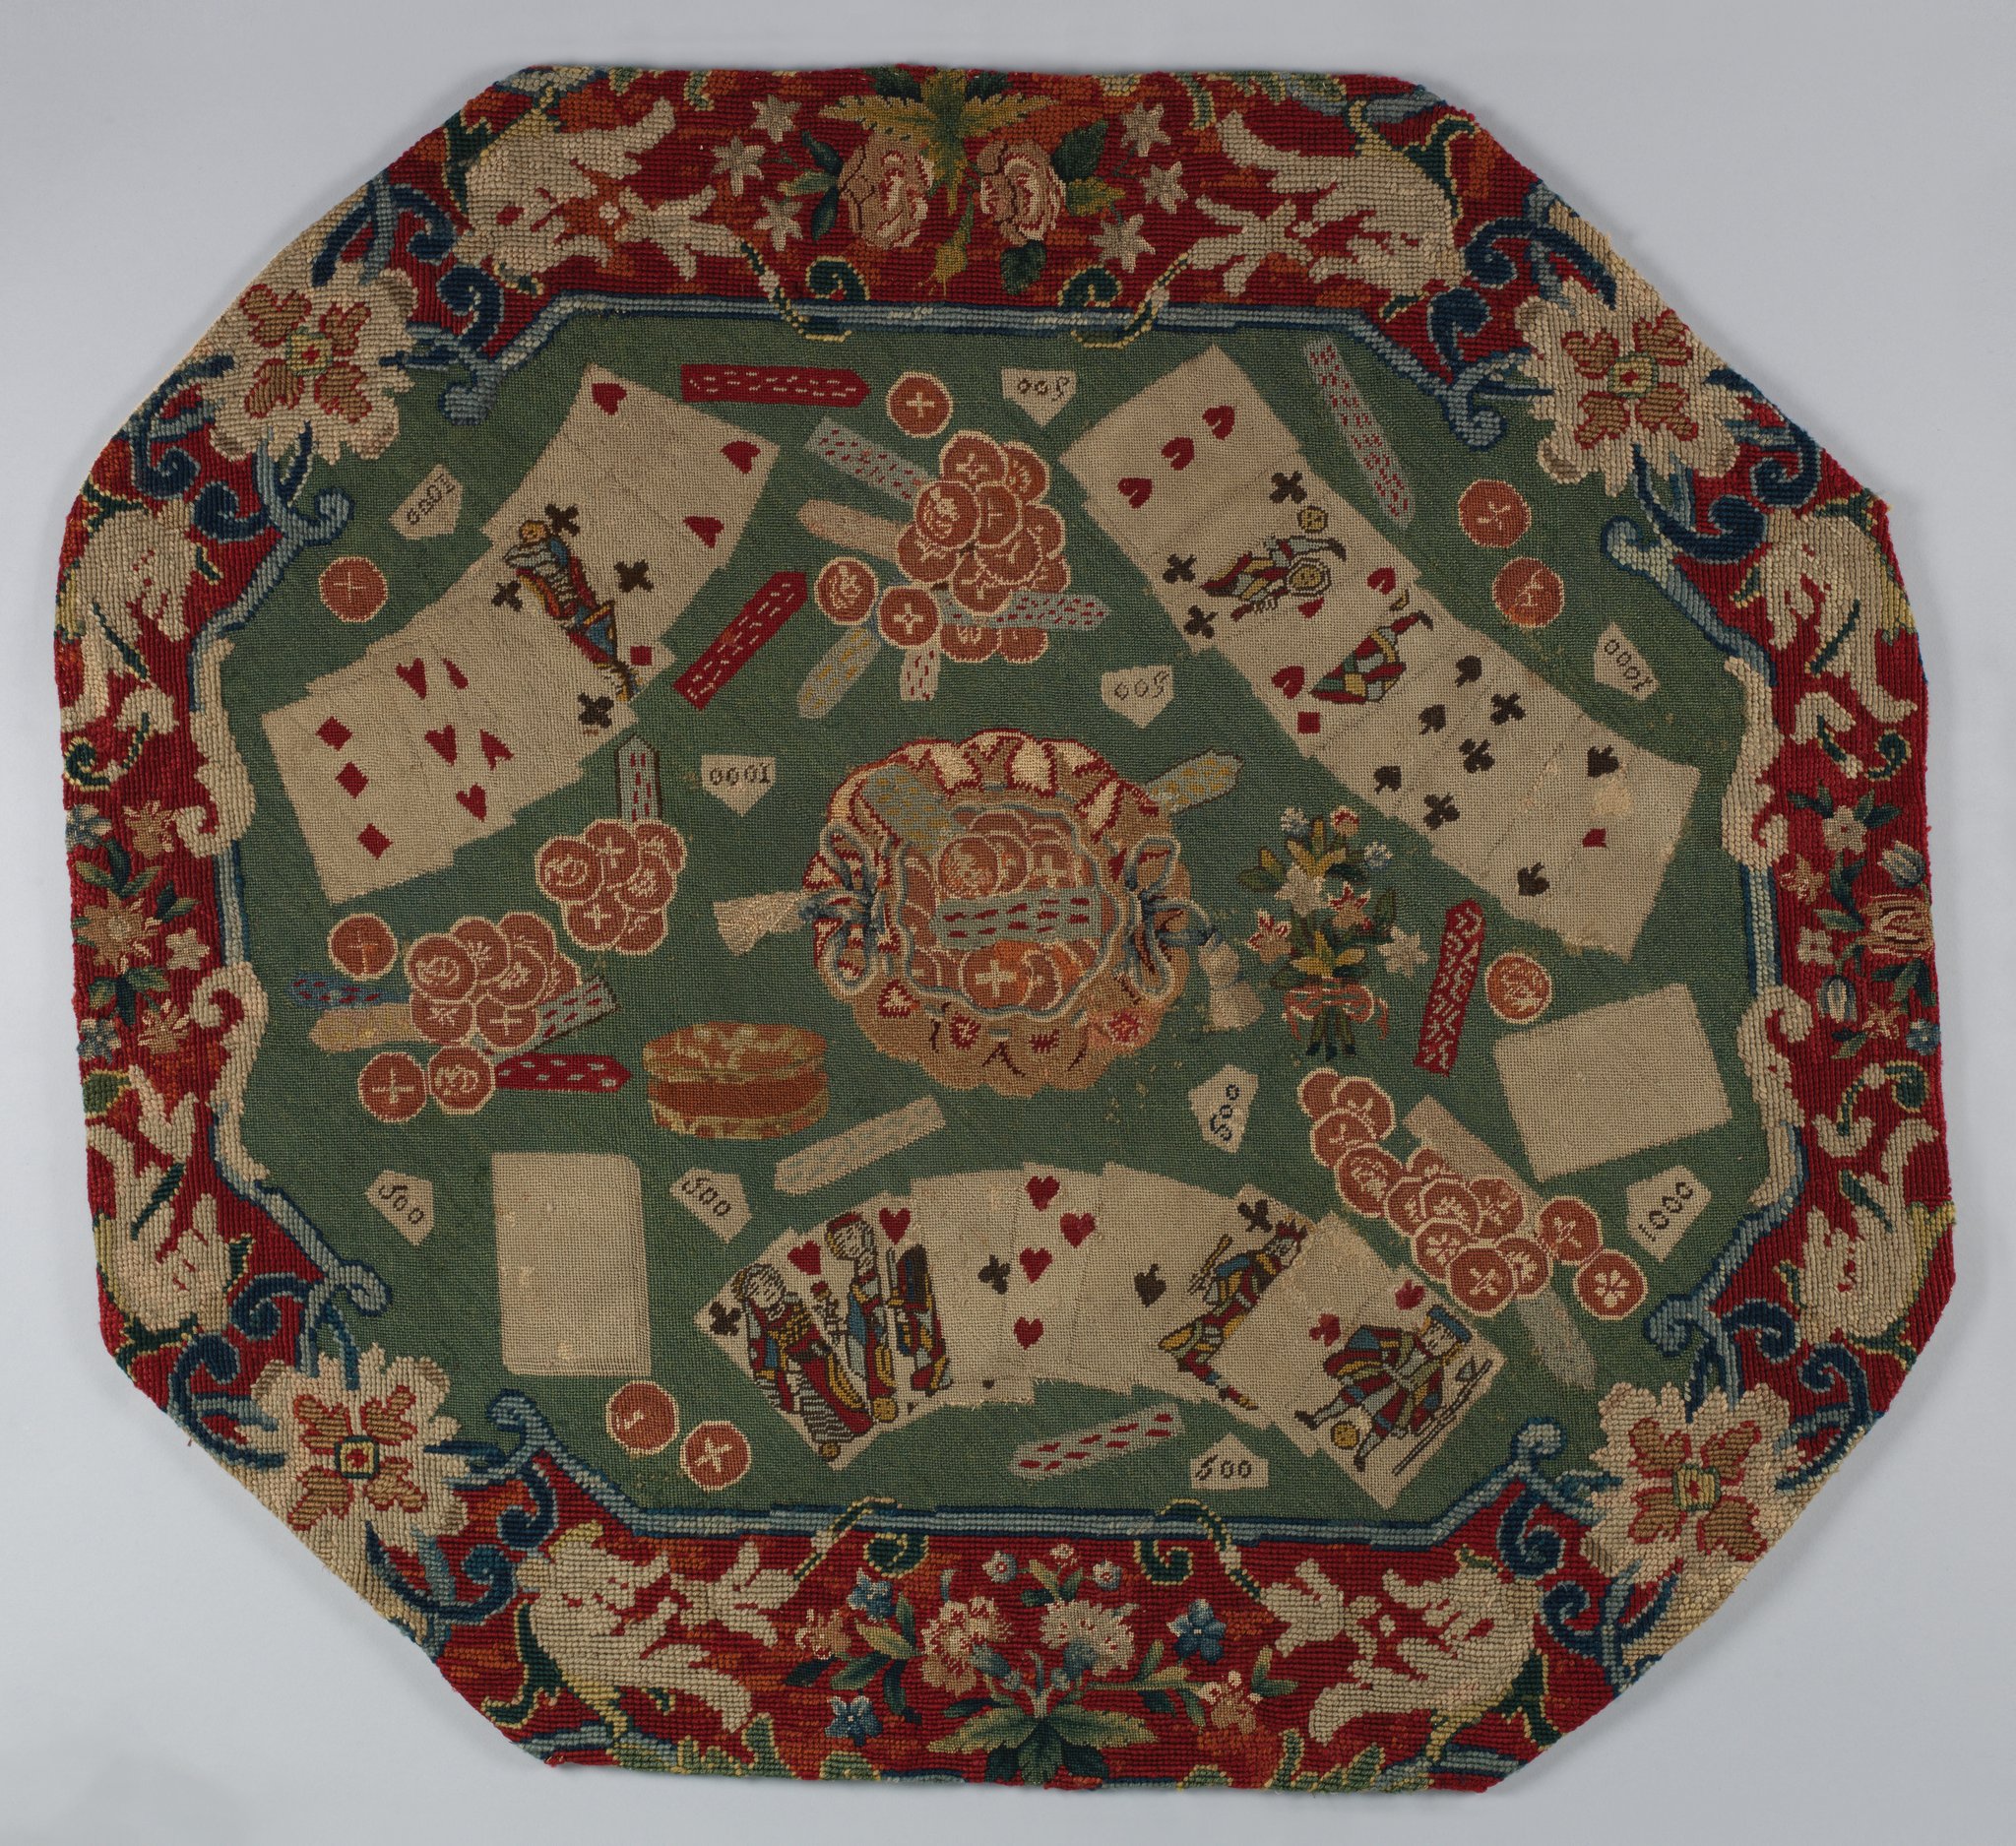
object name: table top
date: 1701-1800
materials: canvas, silk, wool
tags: playing cards,flowers,games